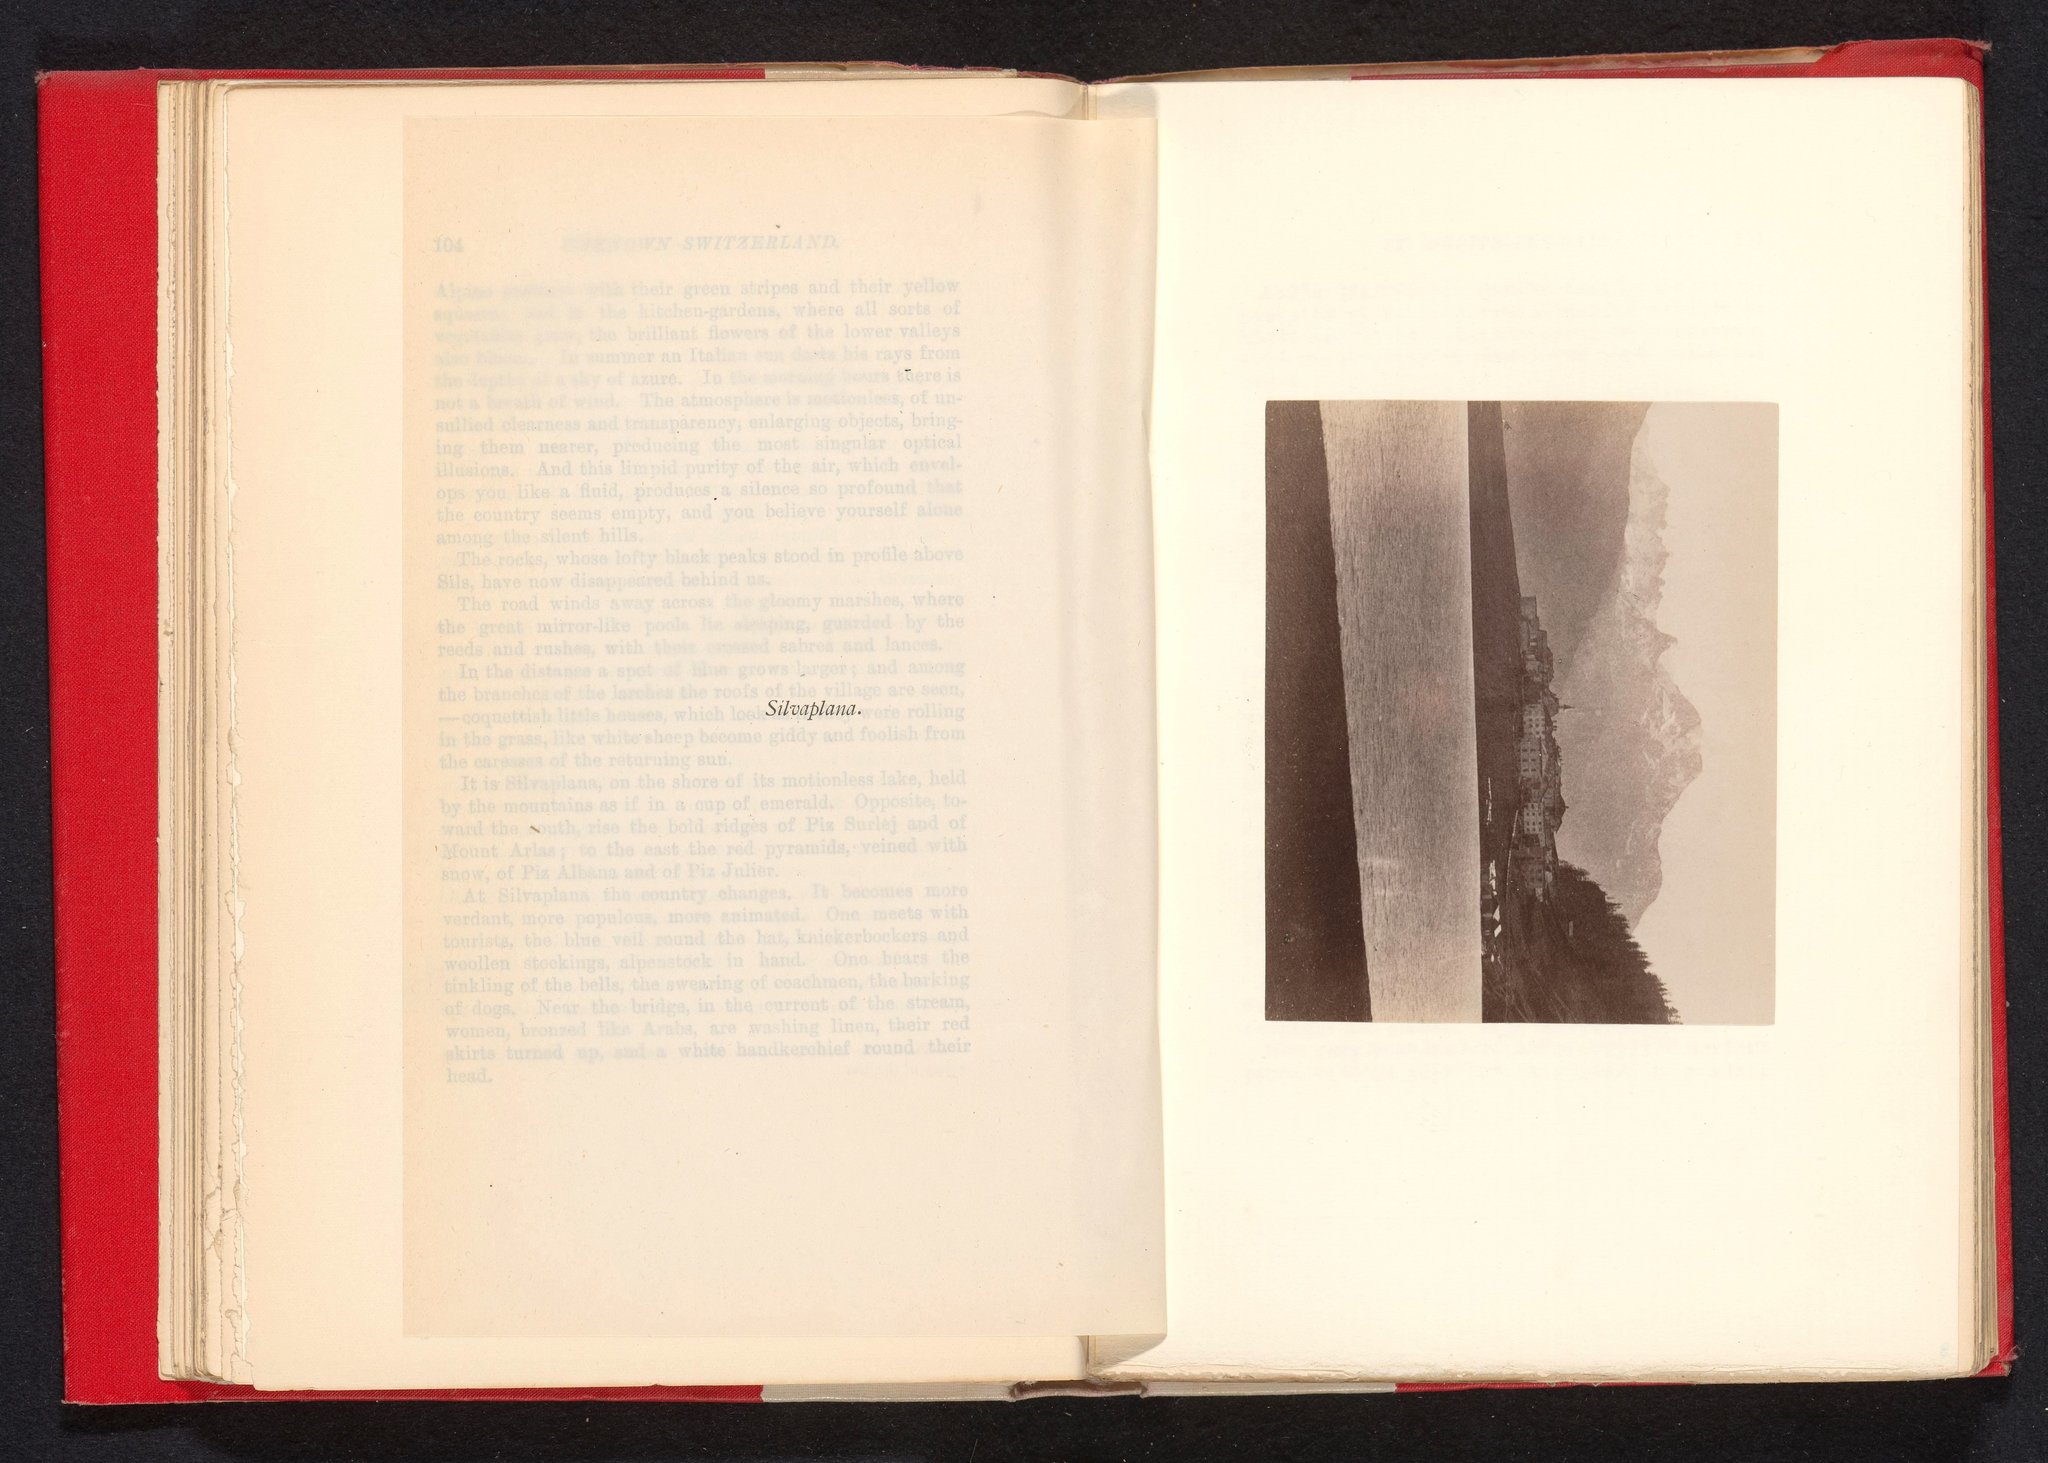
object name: page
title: Gezicht op Silvaplana in Zwitserland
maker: Anonymous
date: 1879-1889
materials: photographic support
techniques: albumen print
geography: graubunden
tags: city-view, and landscape with man-made constructions, lake, mountains